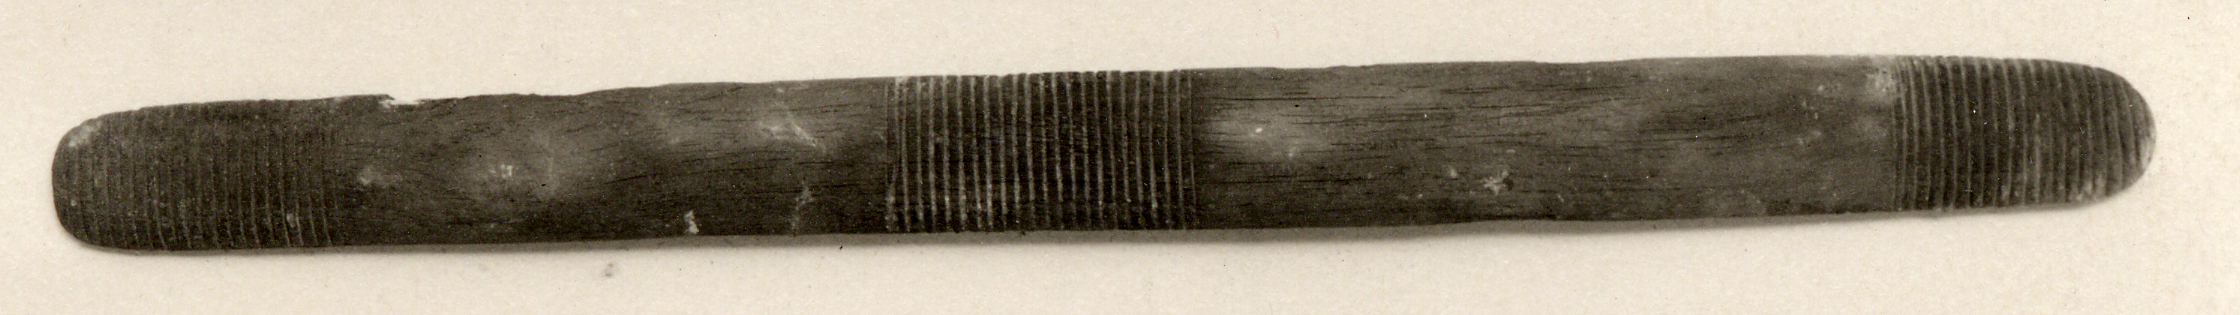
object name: throw stick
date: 1635-1458 BCE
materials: wood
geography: egypt